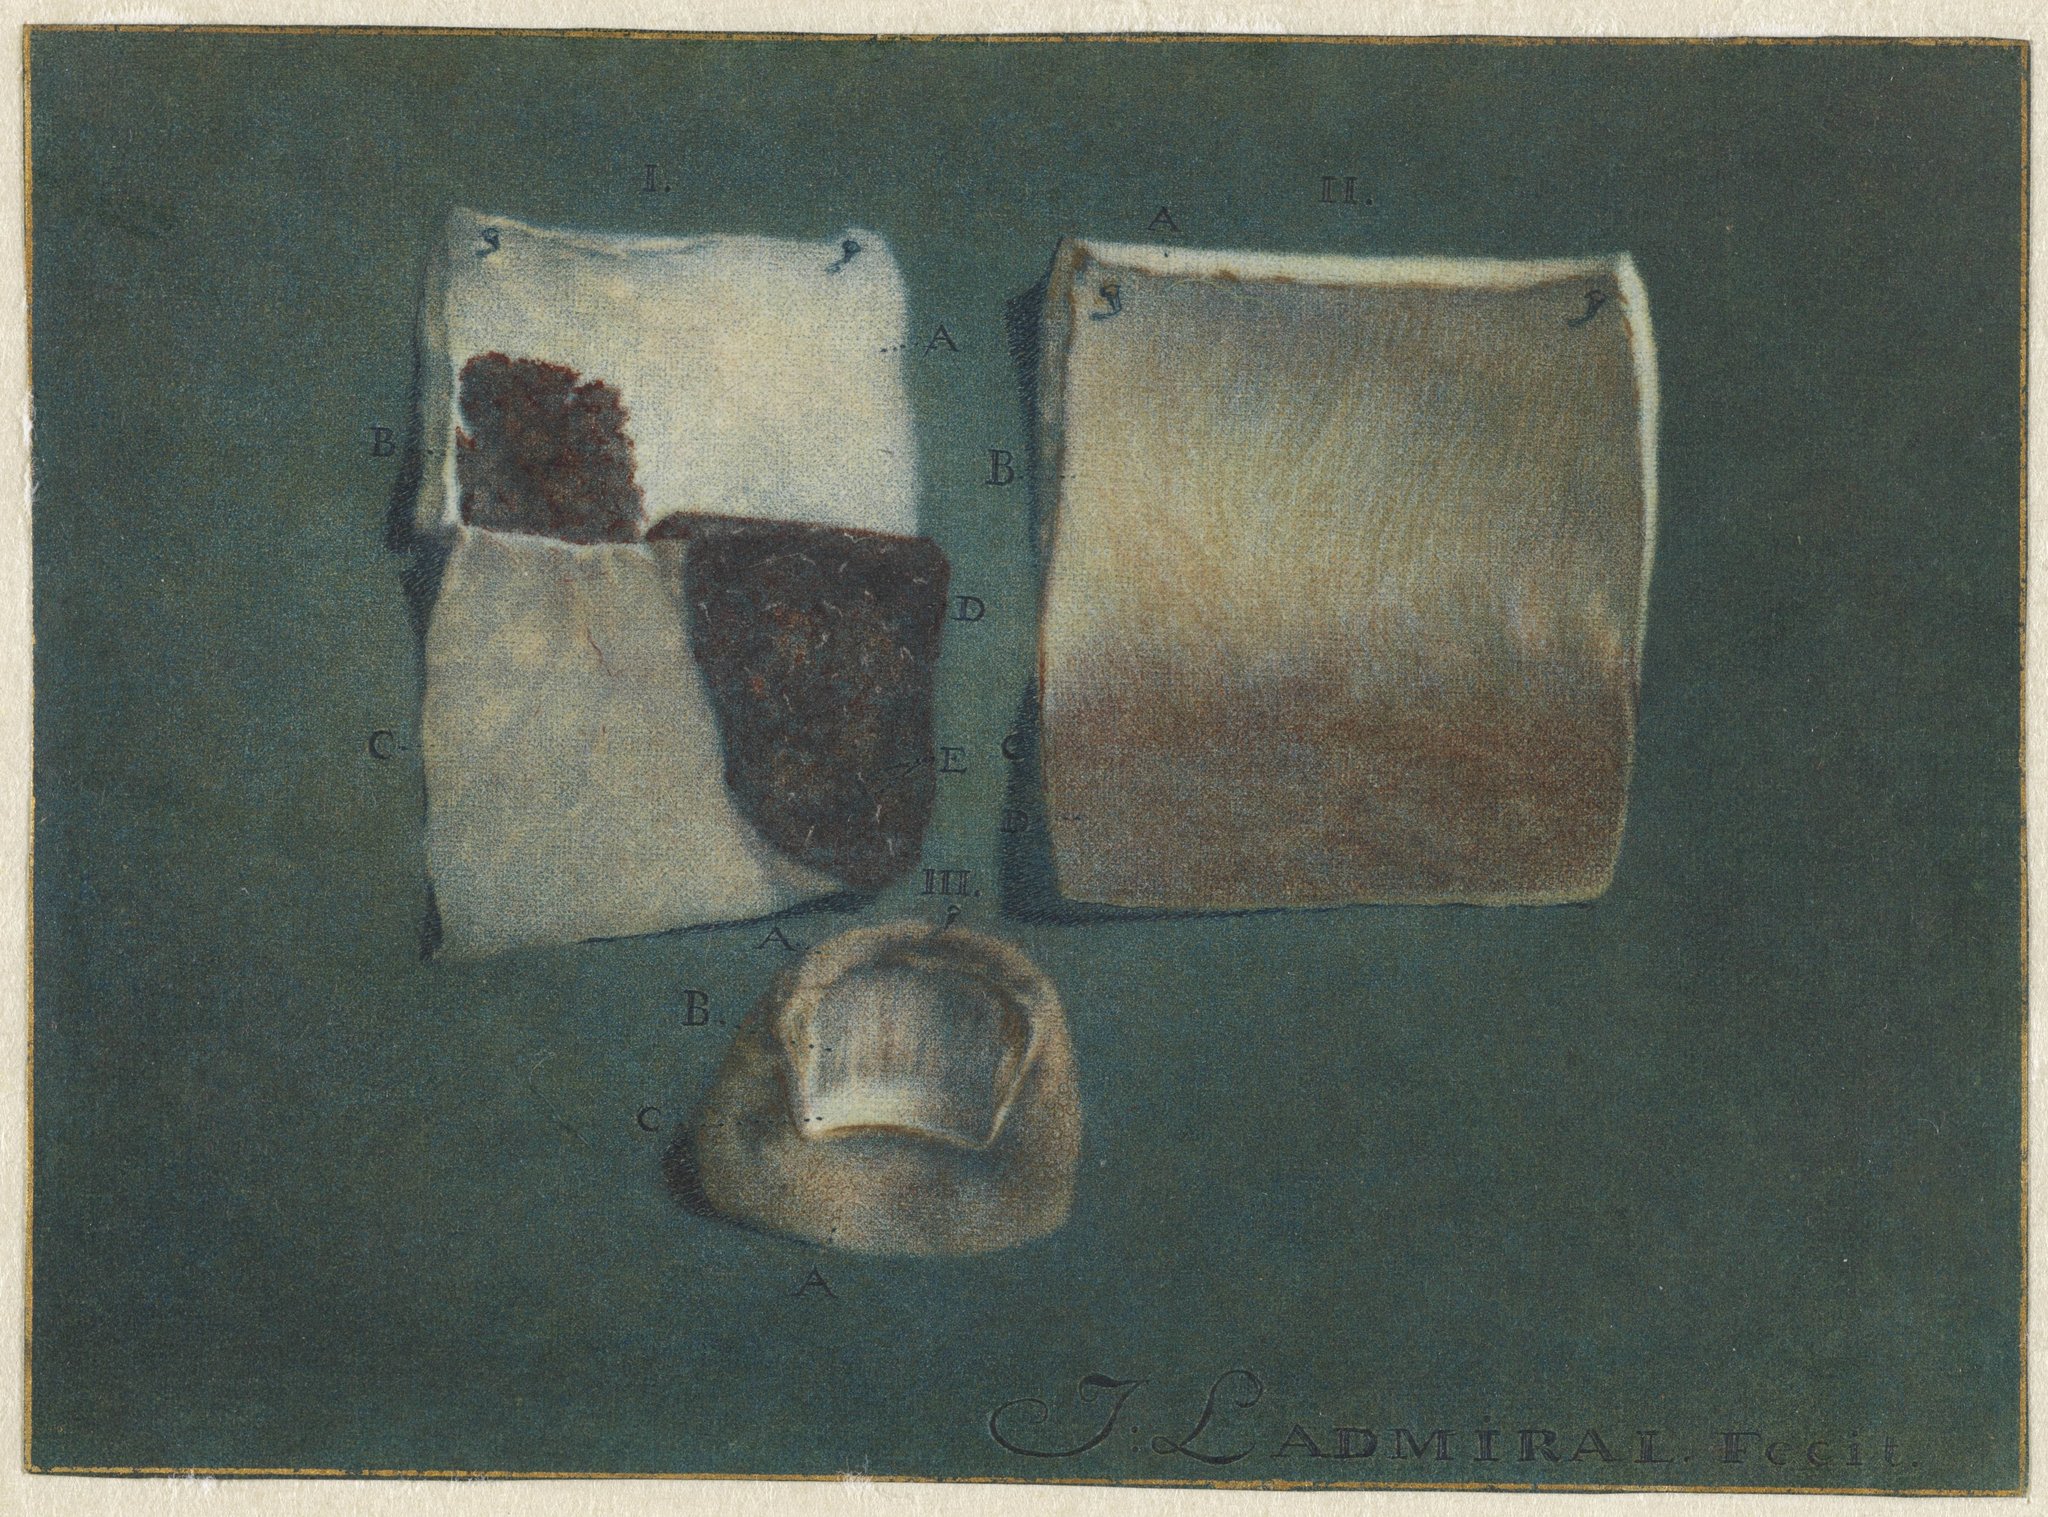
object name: print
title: Anatomische studie van menselijke huid en nagel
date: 1737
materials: paper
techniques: color etching, mezzotint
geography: amsterdam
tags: other anatomical details, skin (human), nails (fingers)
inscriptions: collector's mark: Lugt 2228, collector's mark: Lugt 2760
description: Jan L'Admiral gebruikte voor de groep mezzotinten met het onderwerp 'Anatomische studie van menselijke huid en nagel' vier verschillende platen: A, B, C en D. Mogelijk ook gebruikt als illustratie in: Albinus, Bernhard Siegfried. Dissertatio secunda. De sede et caussa coloris Aethiopum et caeterorum hominum, Leiden: Dirk Haak (II) en Amsterdam: Jacob Graal en Hendrik de Leth, 1737.